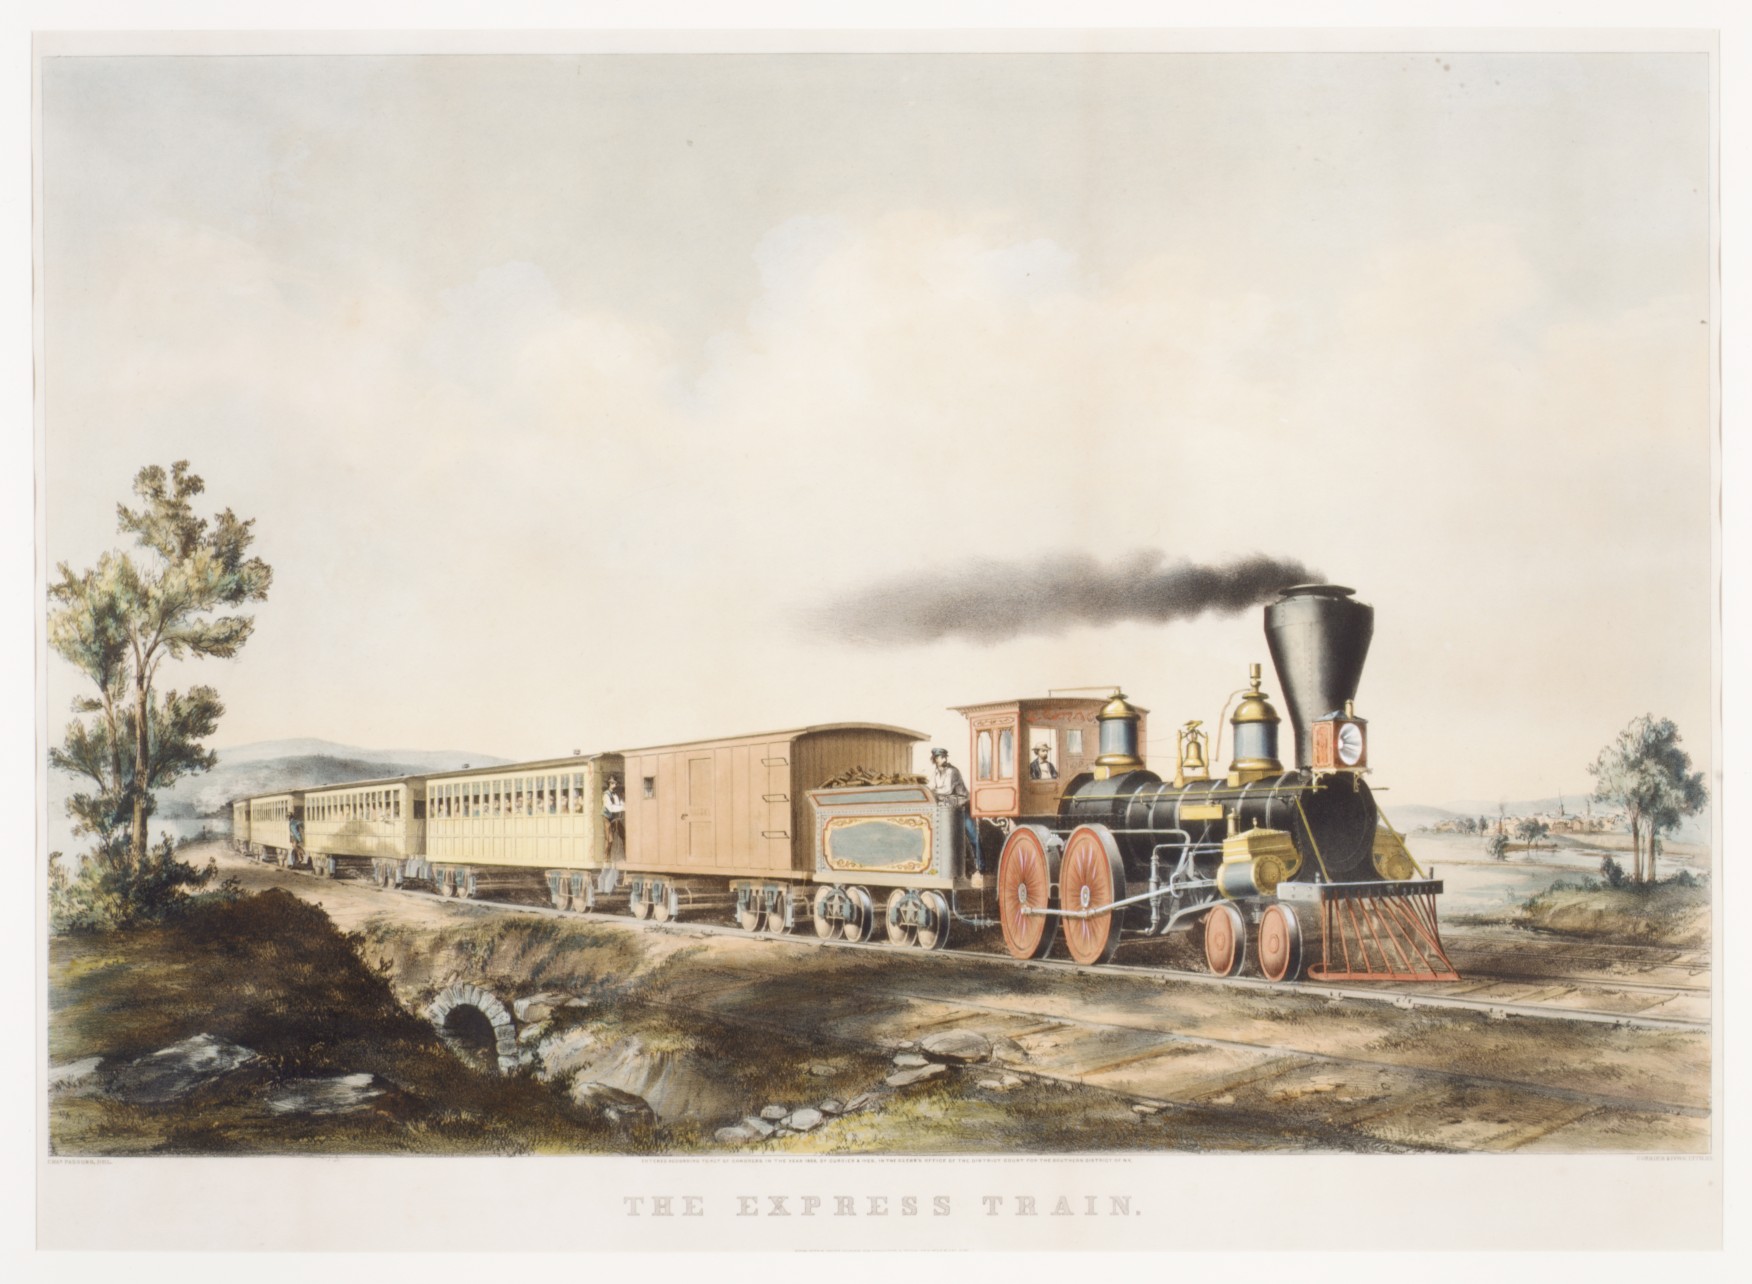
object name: print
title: The Express Train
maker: charles parsons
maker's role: artist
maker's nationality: american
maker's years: 1821-1910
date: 1859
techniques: hand coloring, lithograph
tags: trains